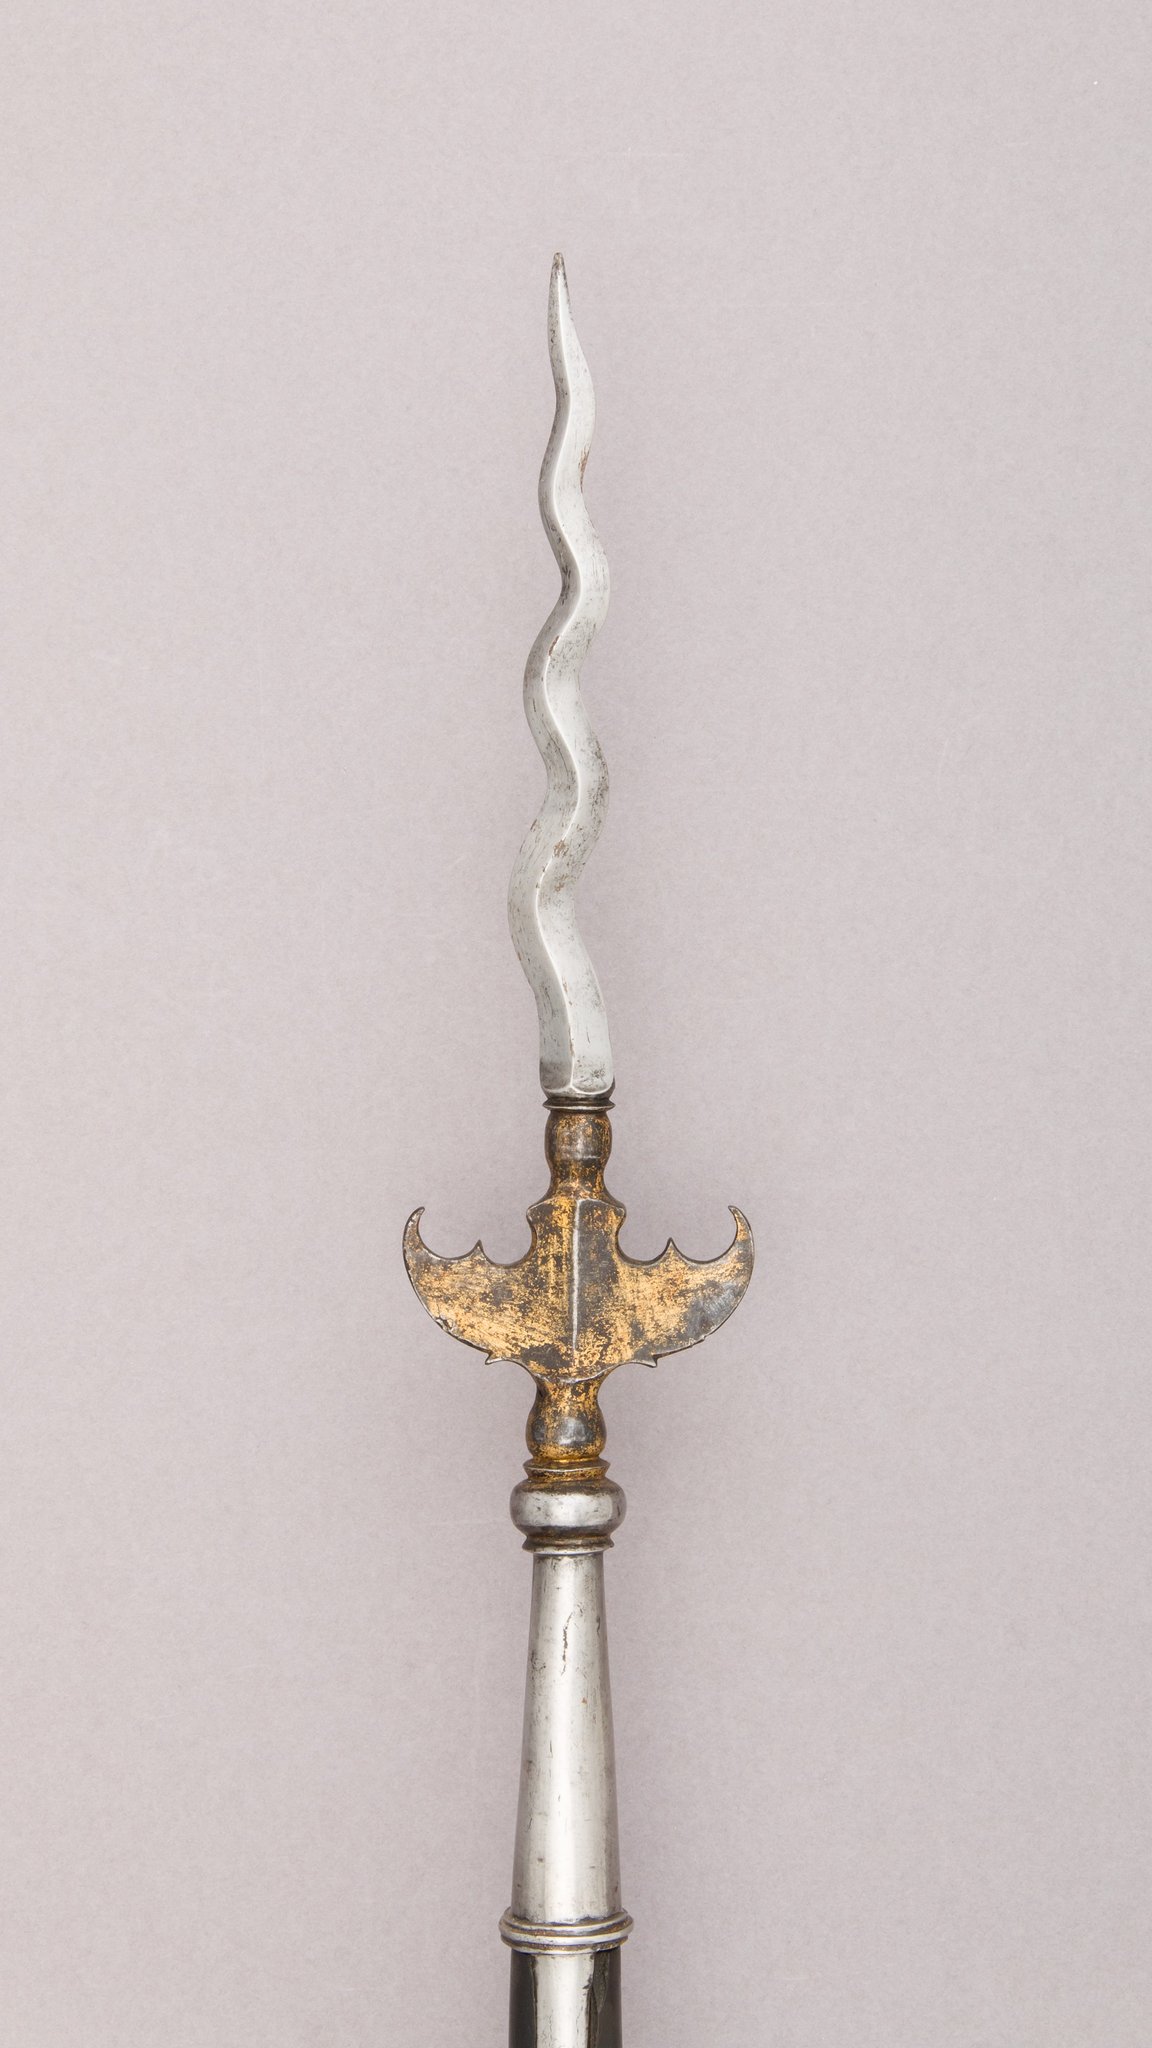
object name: partisan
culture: french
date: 1725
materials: brass, iron, steel, wood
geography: france